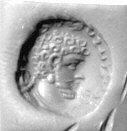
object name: stamp seal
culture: sasanian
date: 267-300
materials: gemstone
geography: iran or mesopotamia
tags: men,profiles